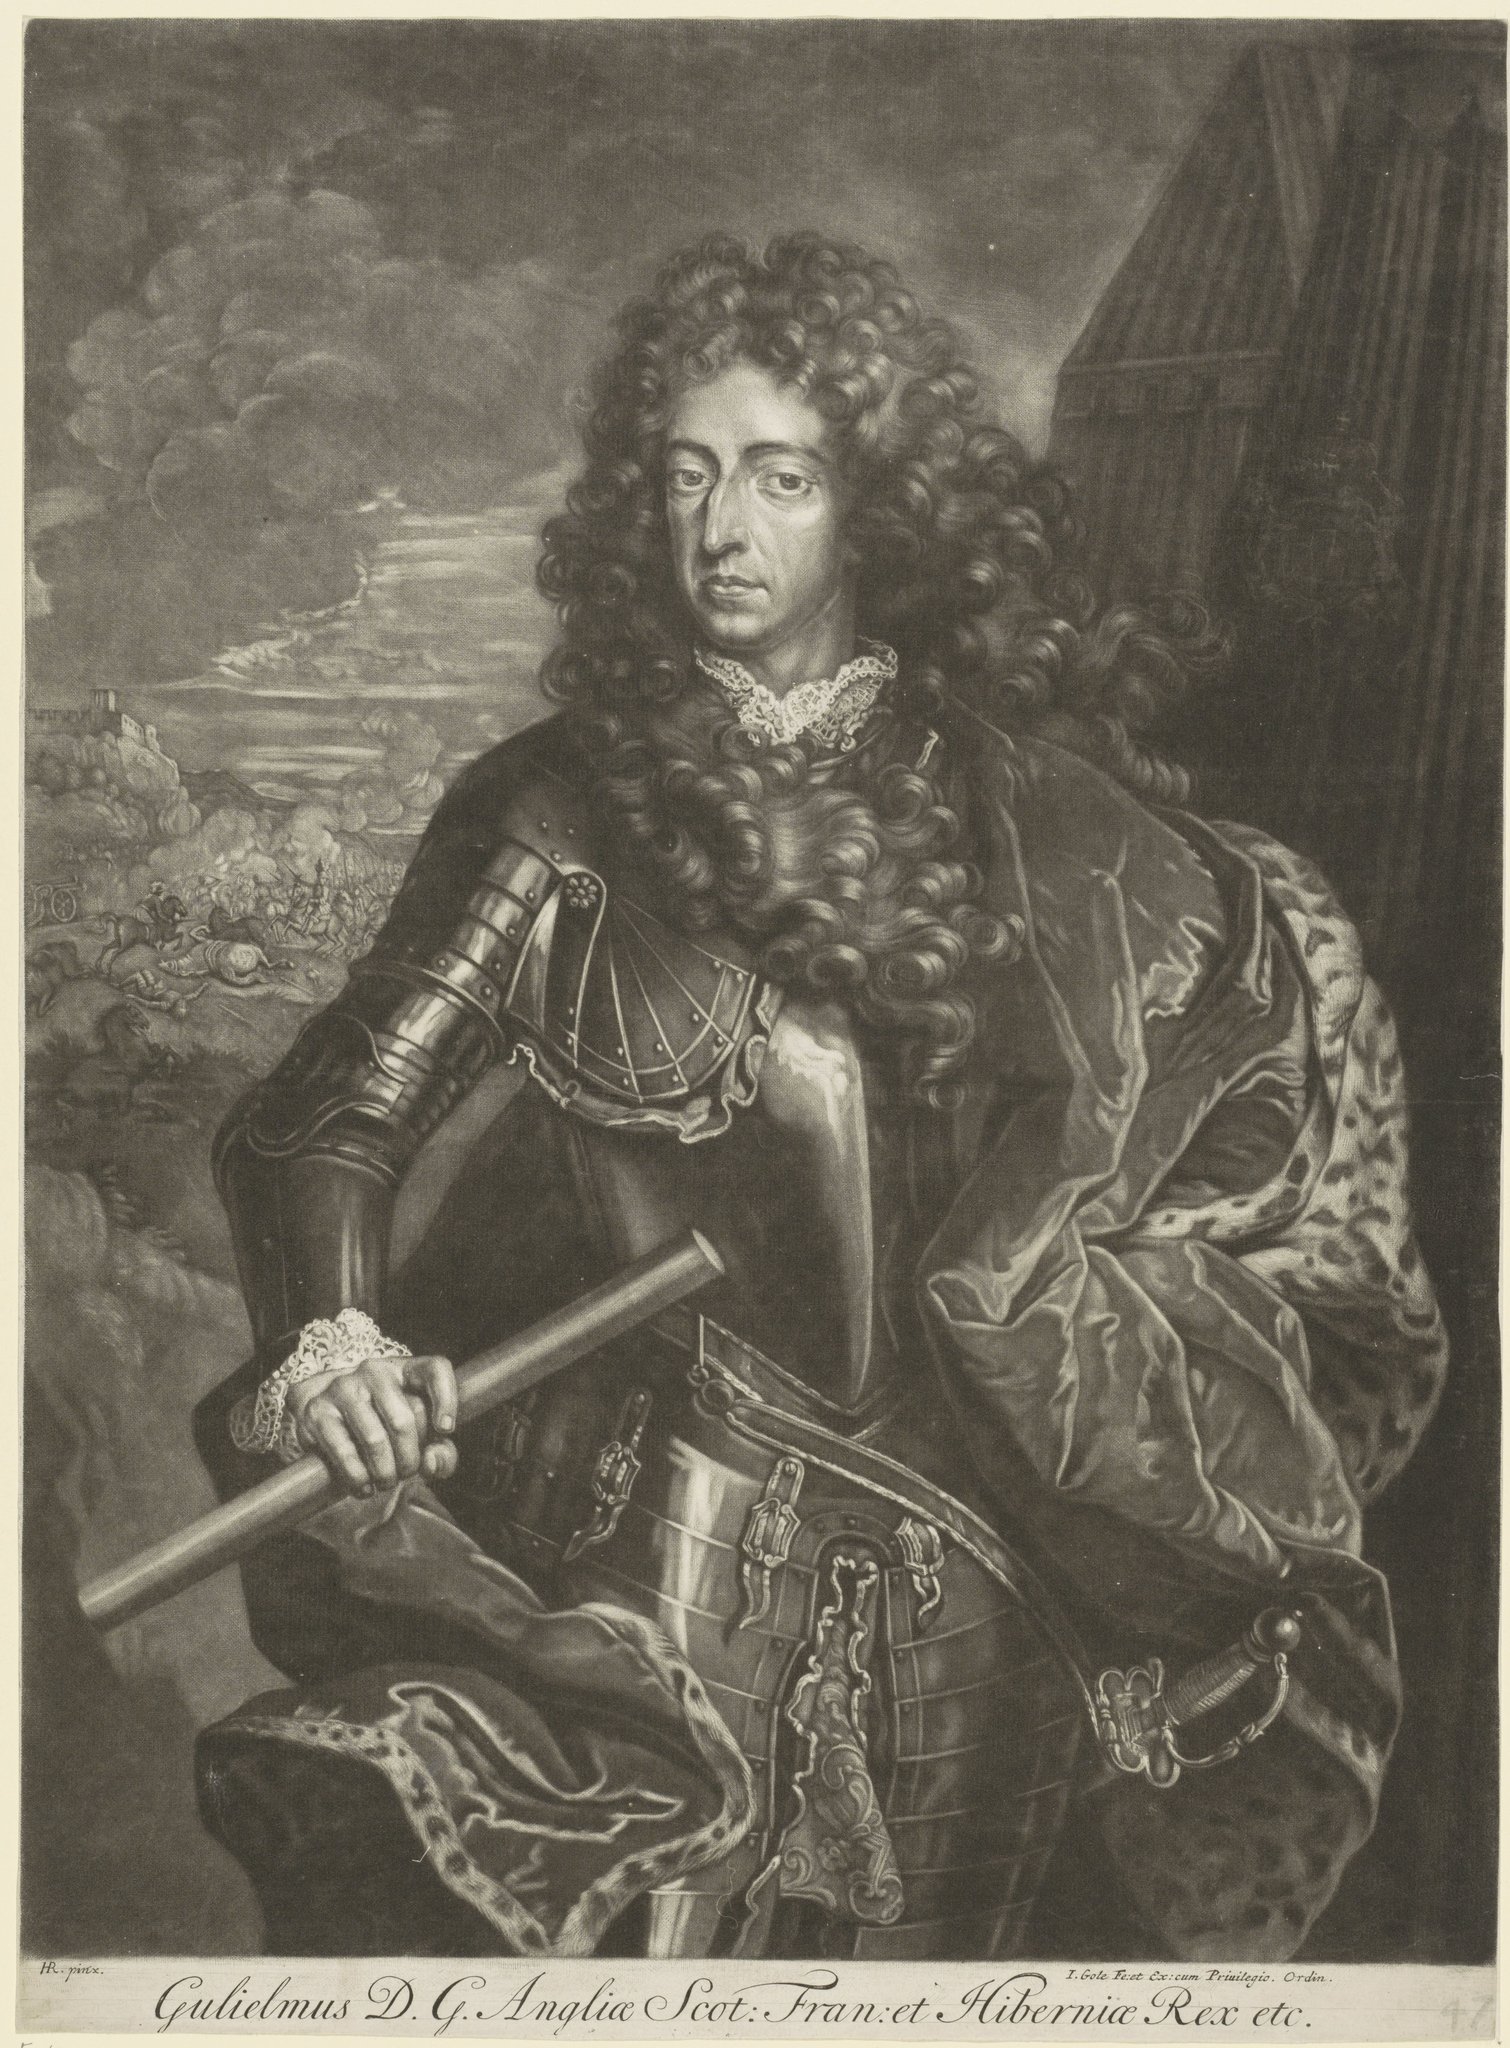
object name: print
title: Portret van Willem III, prins van Oranje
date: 1688-1724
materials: paper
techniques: mezzotint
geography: amsterdam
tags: the hague, william iii (prince of orange and king of england, scotland, and ireland)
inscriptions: collector's mark: Lugt 963, monogram: ‘HR’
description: De hier vermelde titel verwijst naar de hoogst verkregen titel van de geportretteerde, niet per se naar de titel die de geportretteerde op deze voorstelling draagt.